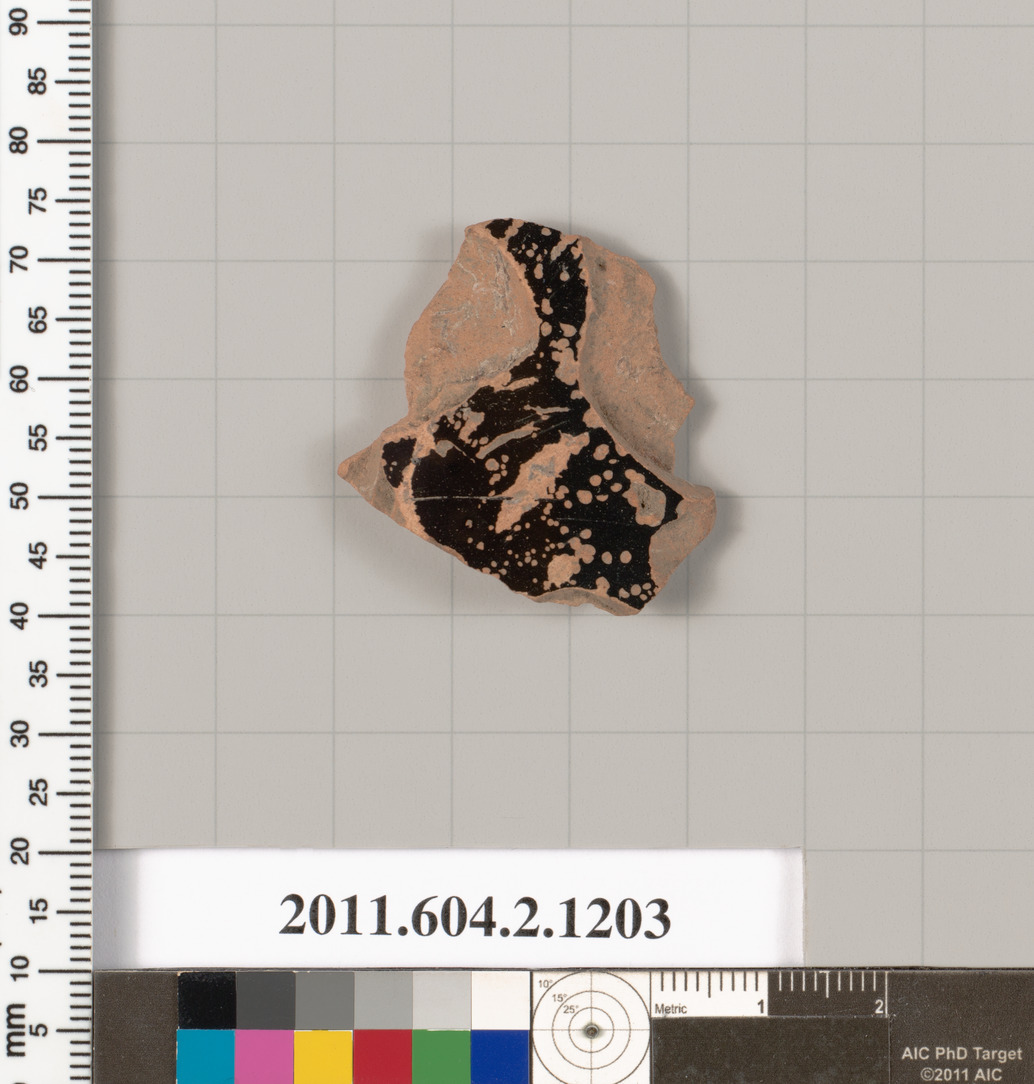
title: Terracotta fragment from a closed shape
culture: greek, attic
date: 500-301 BCE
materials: terracotta